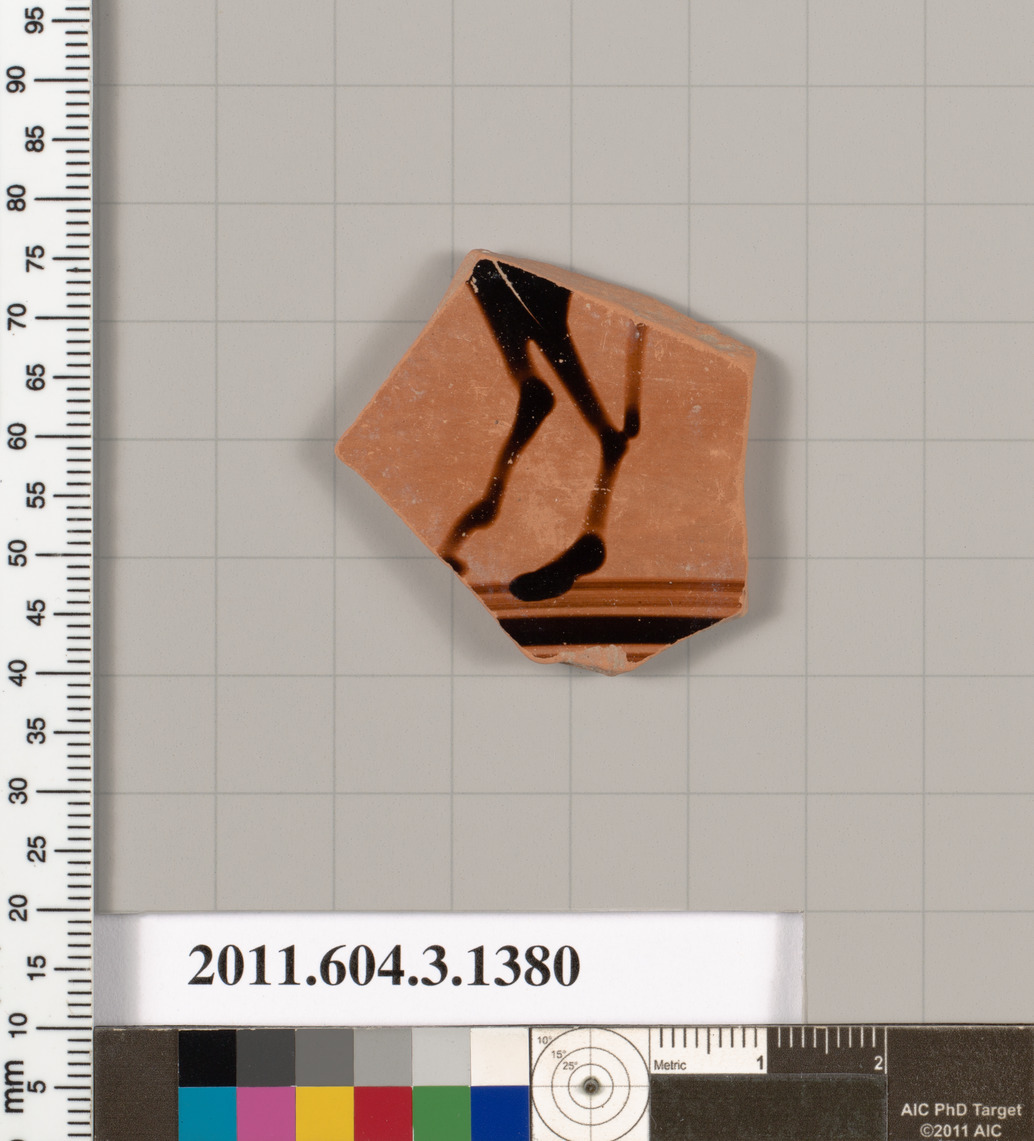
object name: skyphos fragment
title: Terracotta fragment of a skyphos (deep drinking cup)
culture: greek, attic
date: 500-468 BCE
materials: terracotta